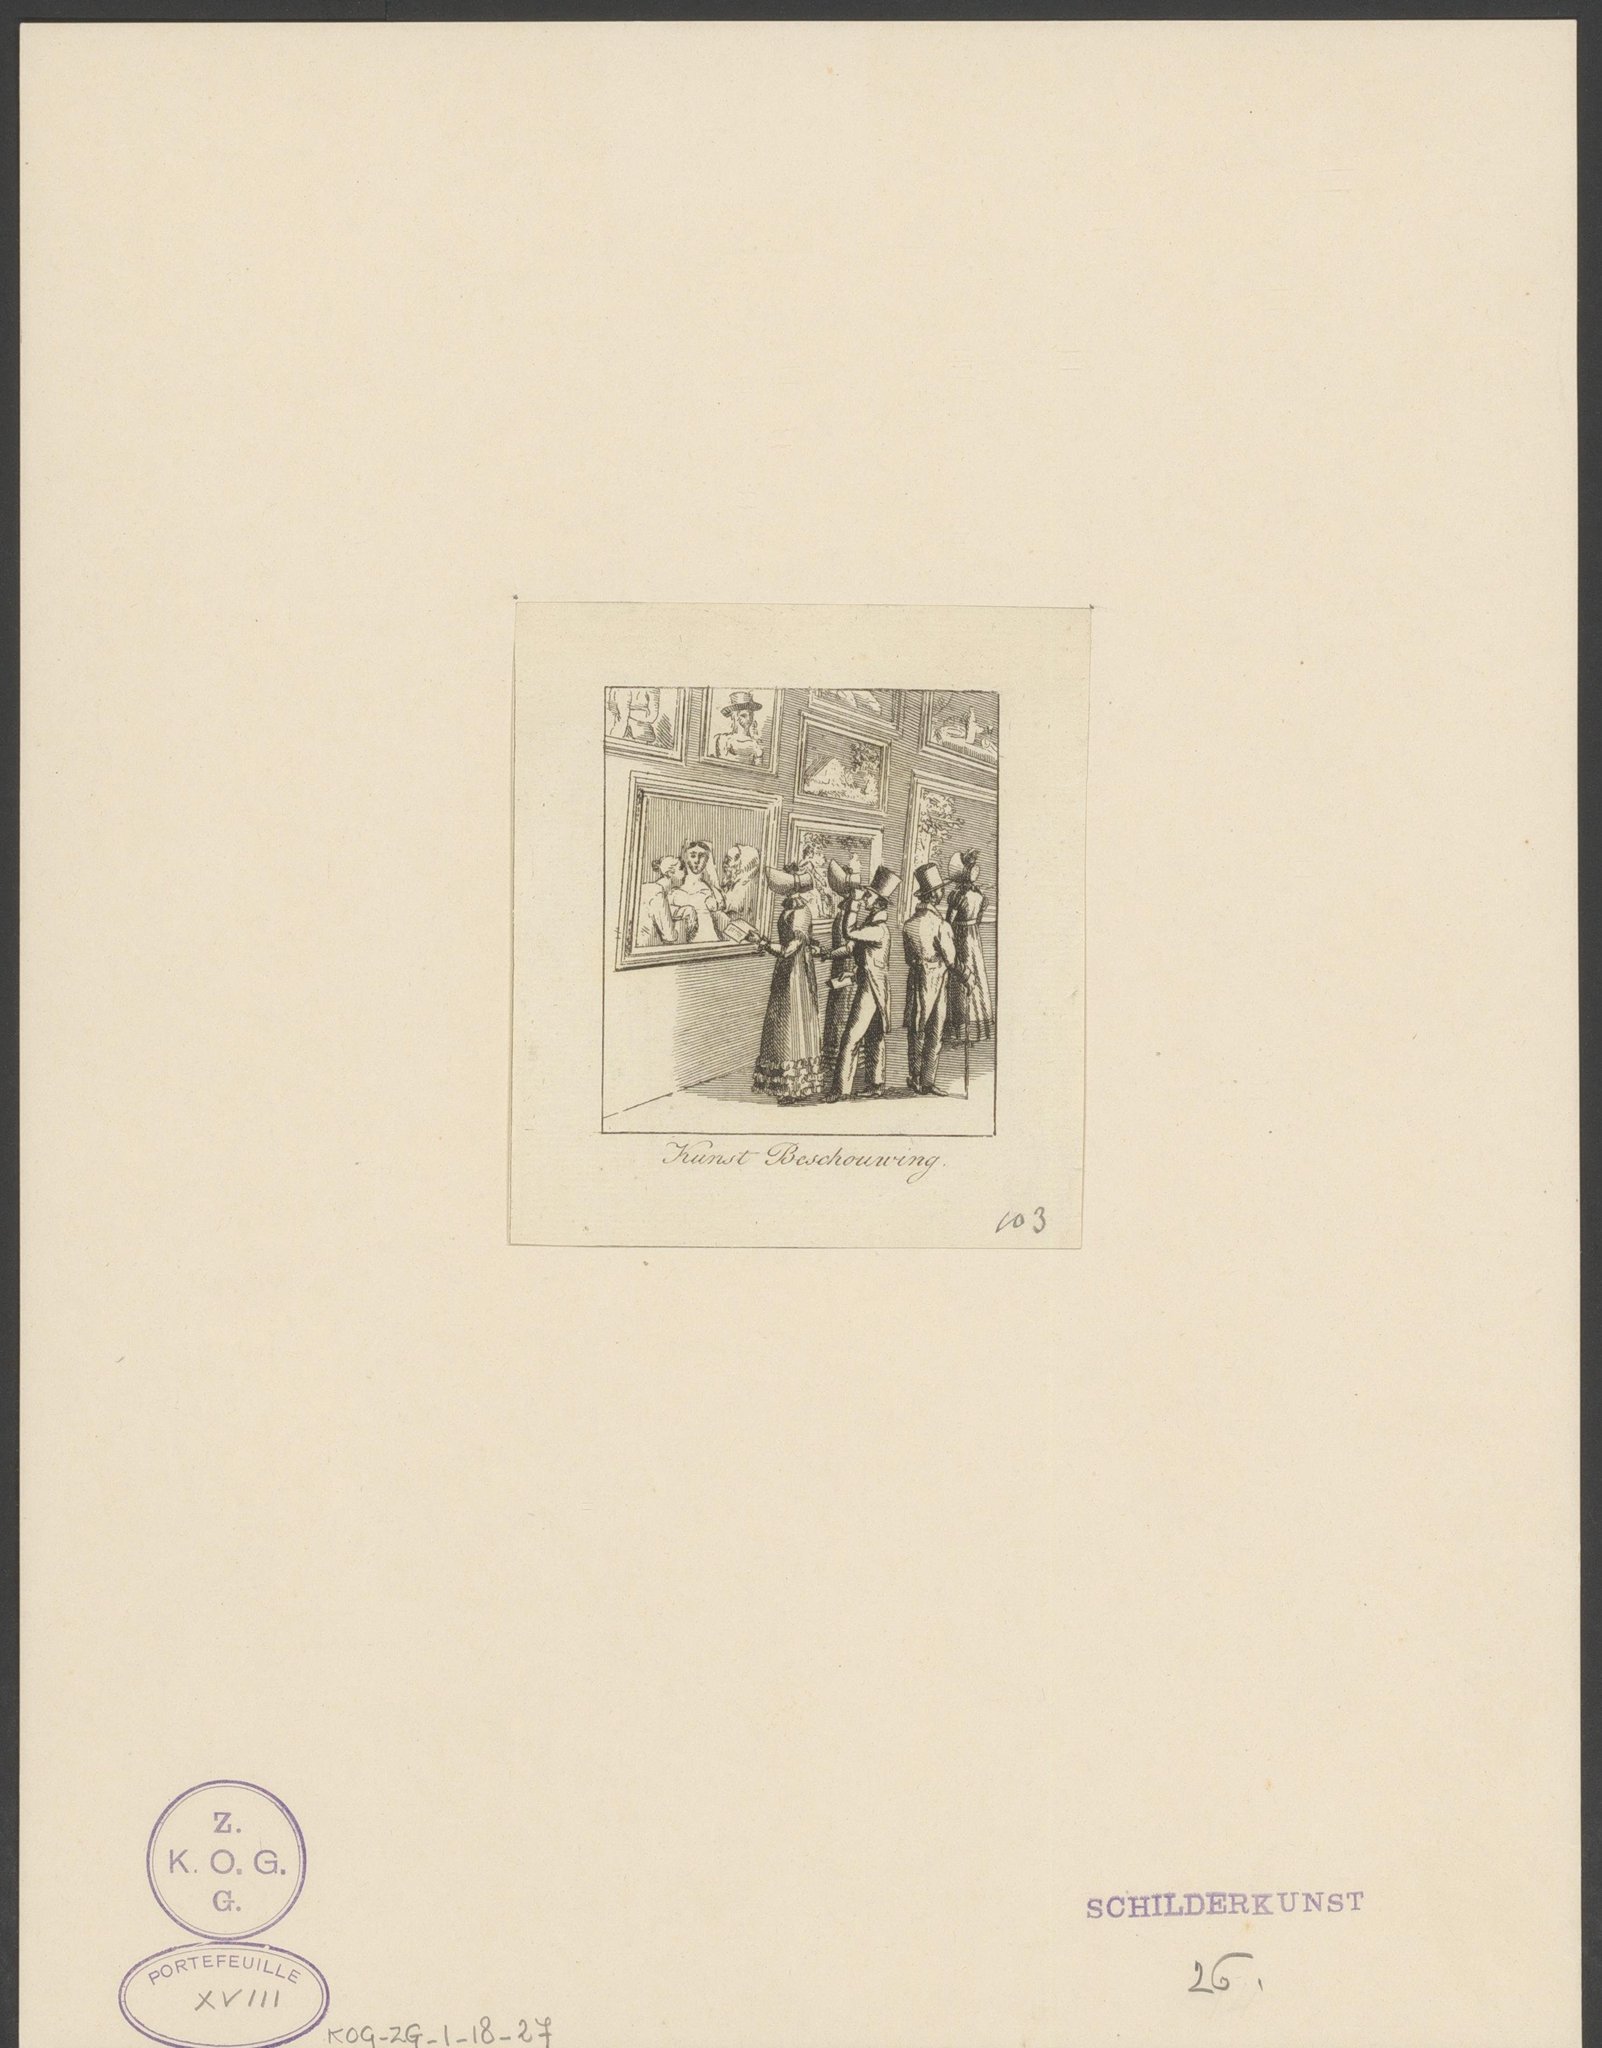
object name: print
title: Drie vrouwen en twee mannen kijken naar schilderijen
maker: Anonymous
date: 1750-1849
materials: paper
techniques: etching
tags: art collection, art gallery, picture, painting, temporary exhibition, 'salon'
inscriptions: stamp, collector's mark: Lugt 1641, stamp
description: Onderwerpsrubrieken binnen de Atlas Zeden en Gewoonten: Schoone kunsten, Schilderkunst, Kunstbeschouwingen.